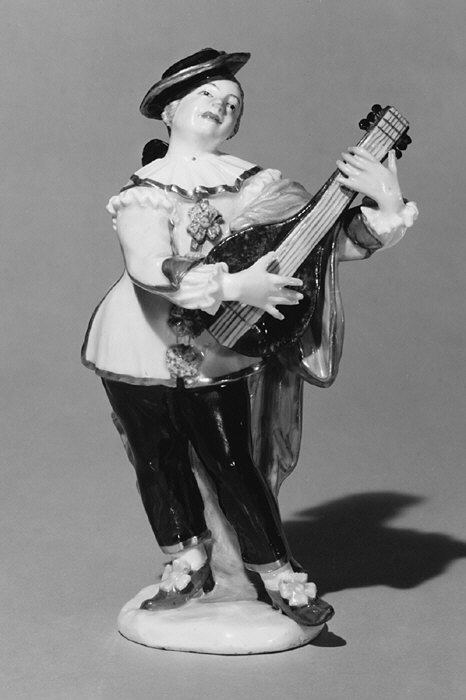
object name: figure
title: Musician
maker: meissen manufactory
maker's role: manufactory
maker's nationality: german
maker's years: 1710-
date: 1739-1740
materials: hard paste porcelain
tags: musical instruments,women,musicians